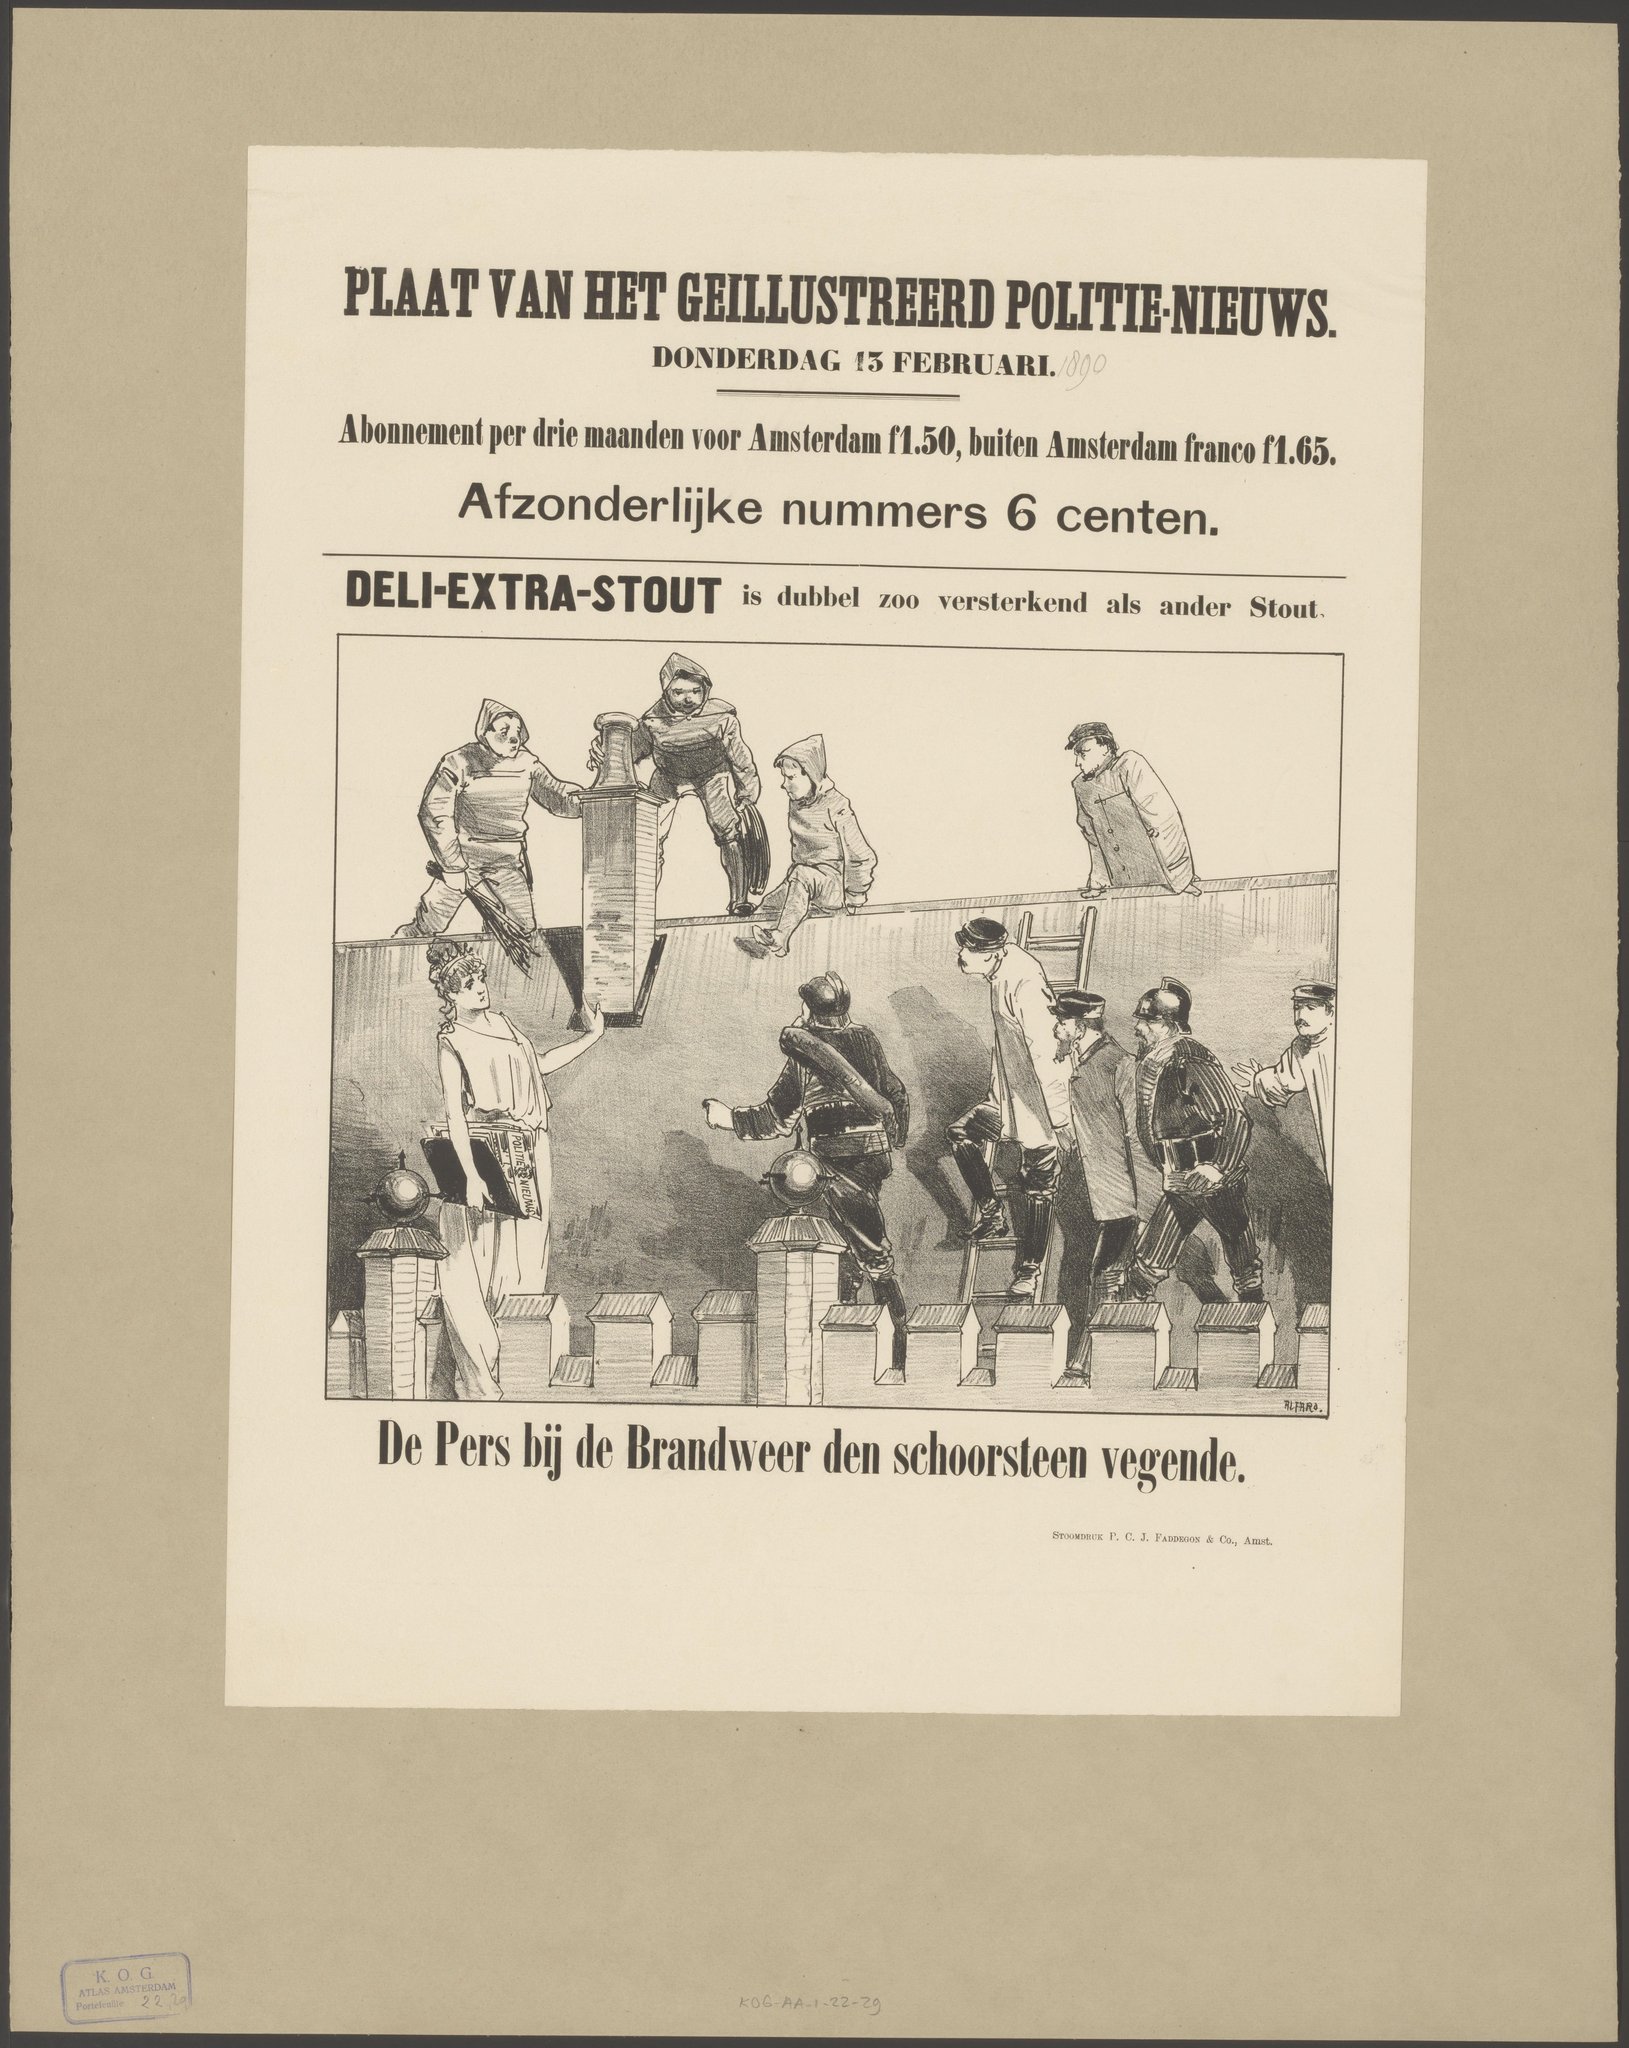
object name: cartoon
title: De Pers bij de Brandweer den schoorsteen vegende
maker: alfaro reijding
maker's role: draughtsman, engineer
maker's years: 1863-1930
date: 1890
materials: paper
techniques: letterpress printing, lithograph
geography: amsterdam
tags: chimney, roof (of house or building), firemen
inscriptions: collector's mark: Lugt 1641b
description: Gepubliceerd als bijvoegsel van 'Geïllustreerd Politie-Nieuws', 13 februari 1890.